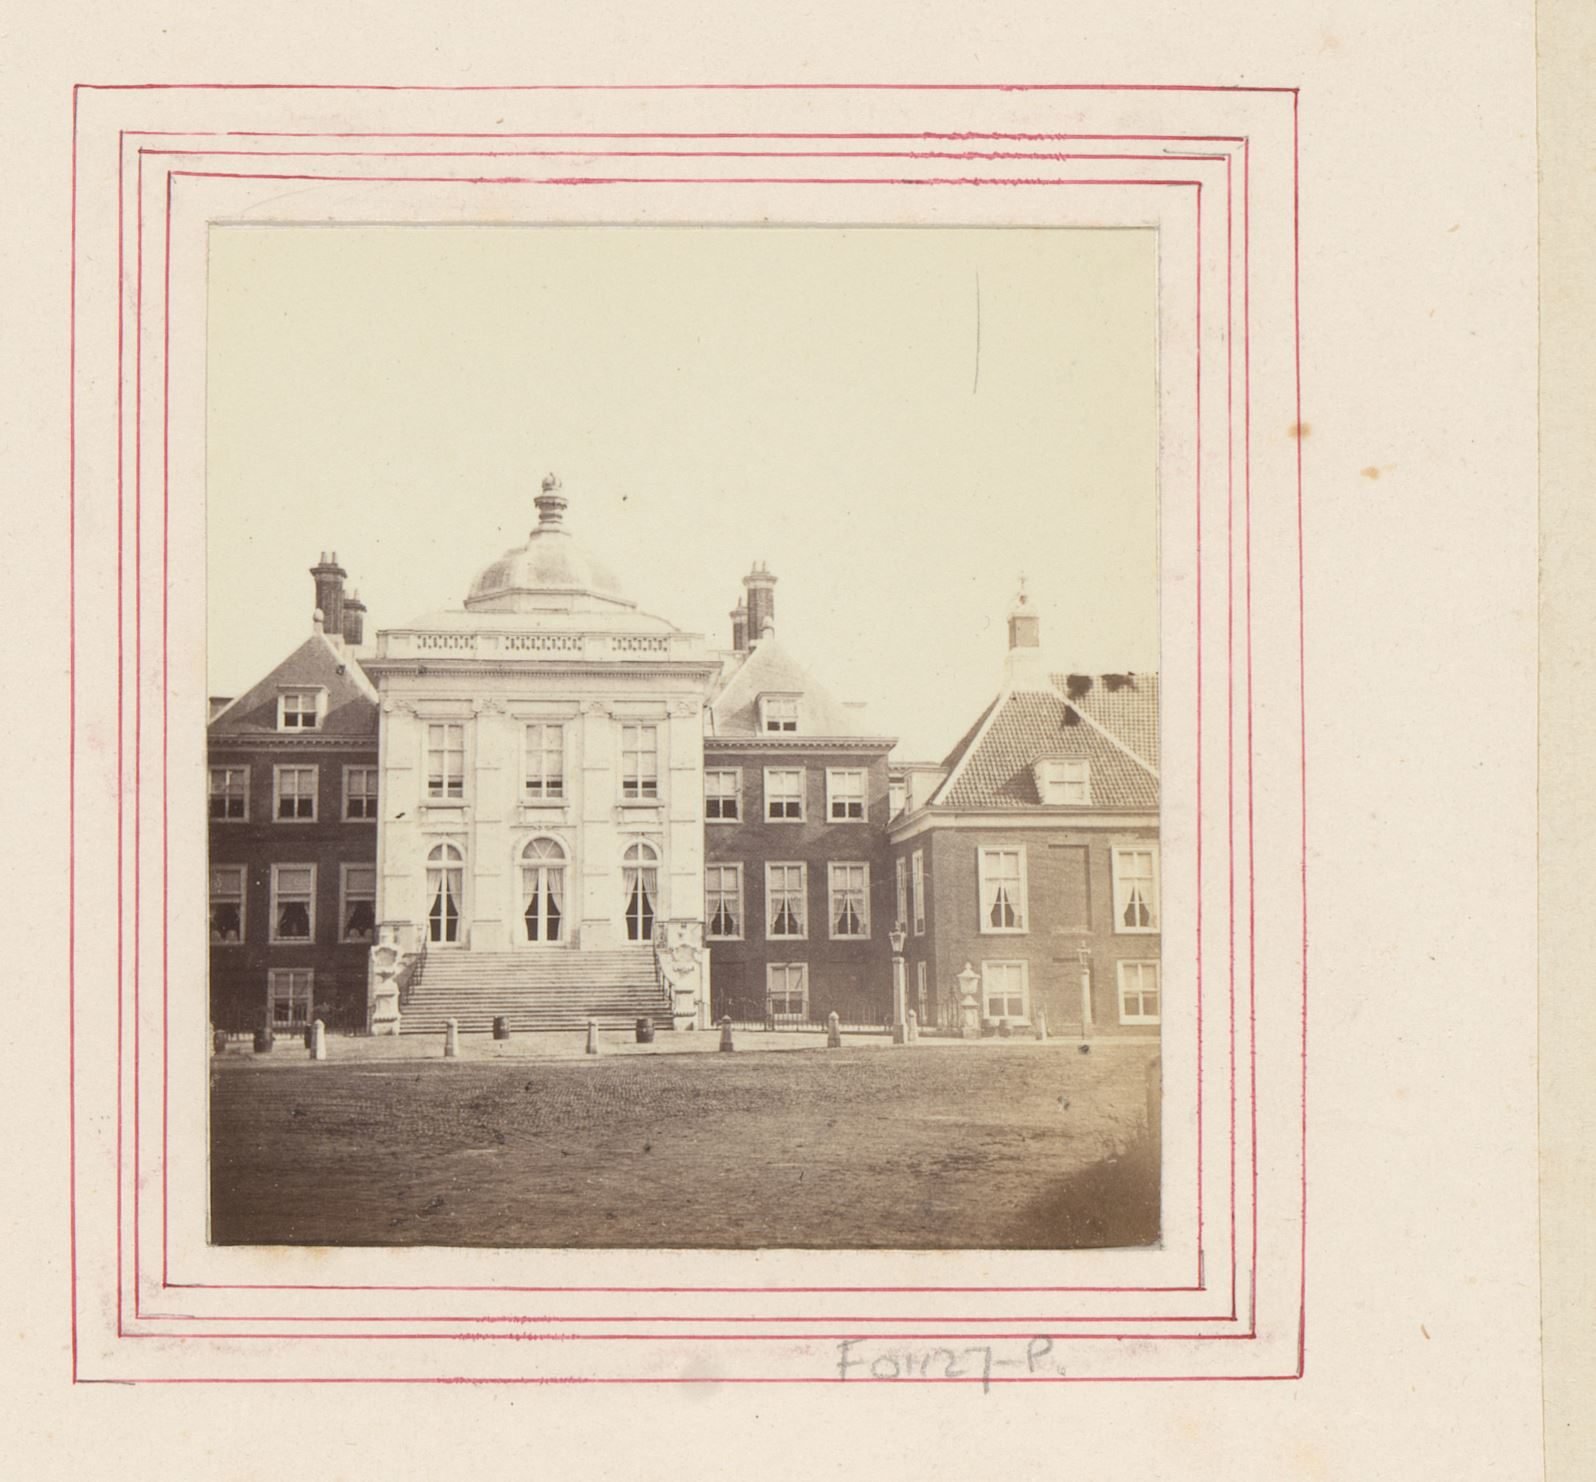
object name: photograph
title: Voorzijde van Paleis Huis ten Bosch in Den Haag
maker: Anonymous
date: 1870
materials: photographic support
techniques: albumen print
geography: the hague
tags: palace, façade (of house or building)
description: Onderdeel van Album met foto's en litho's van bezienswaardigheden in Noord- en Zuid-Hollandse steden, schilderijen en klederdrachten.